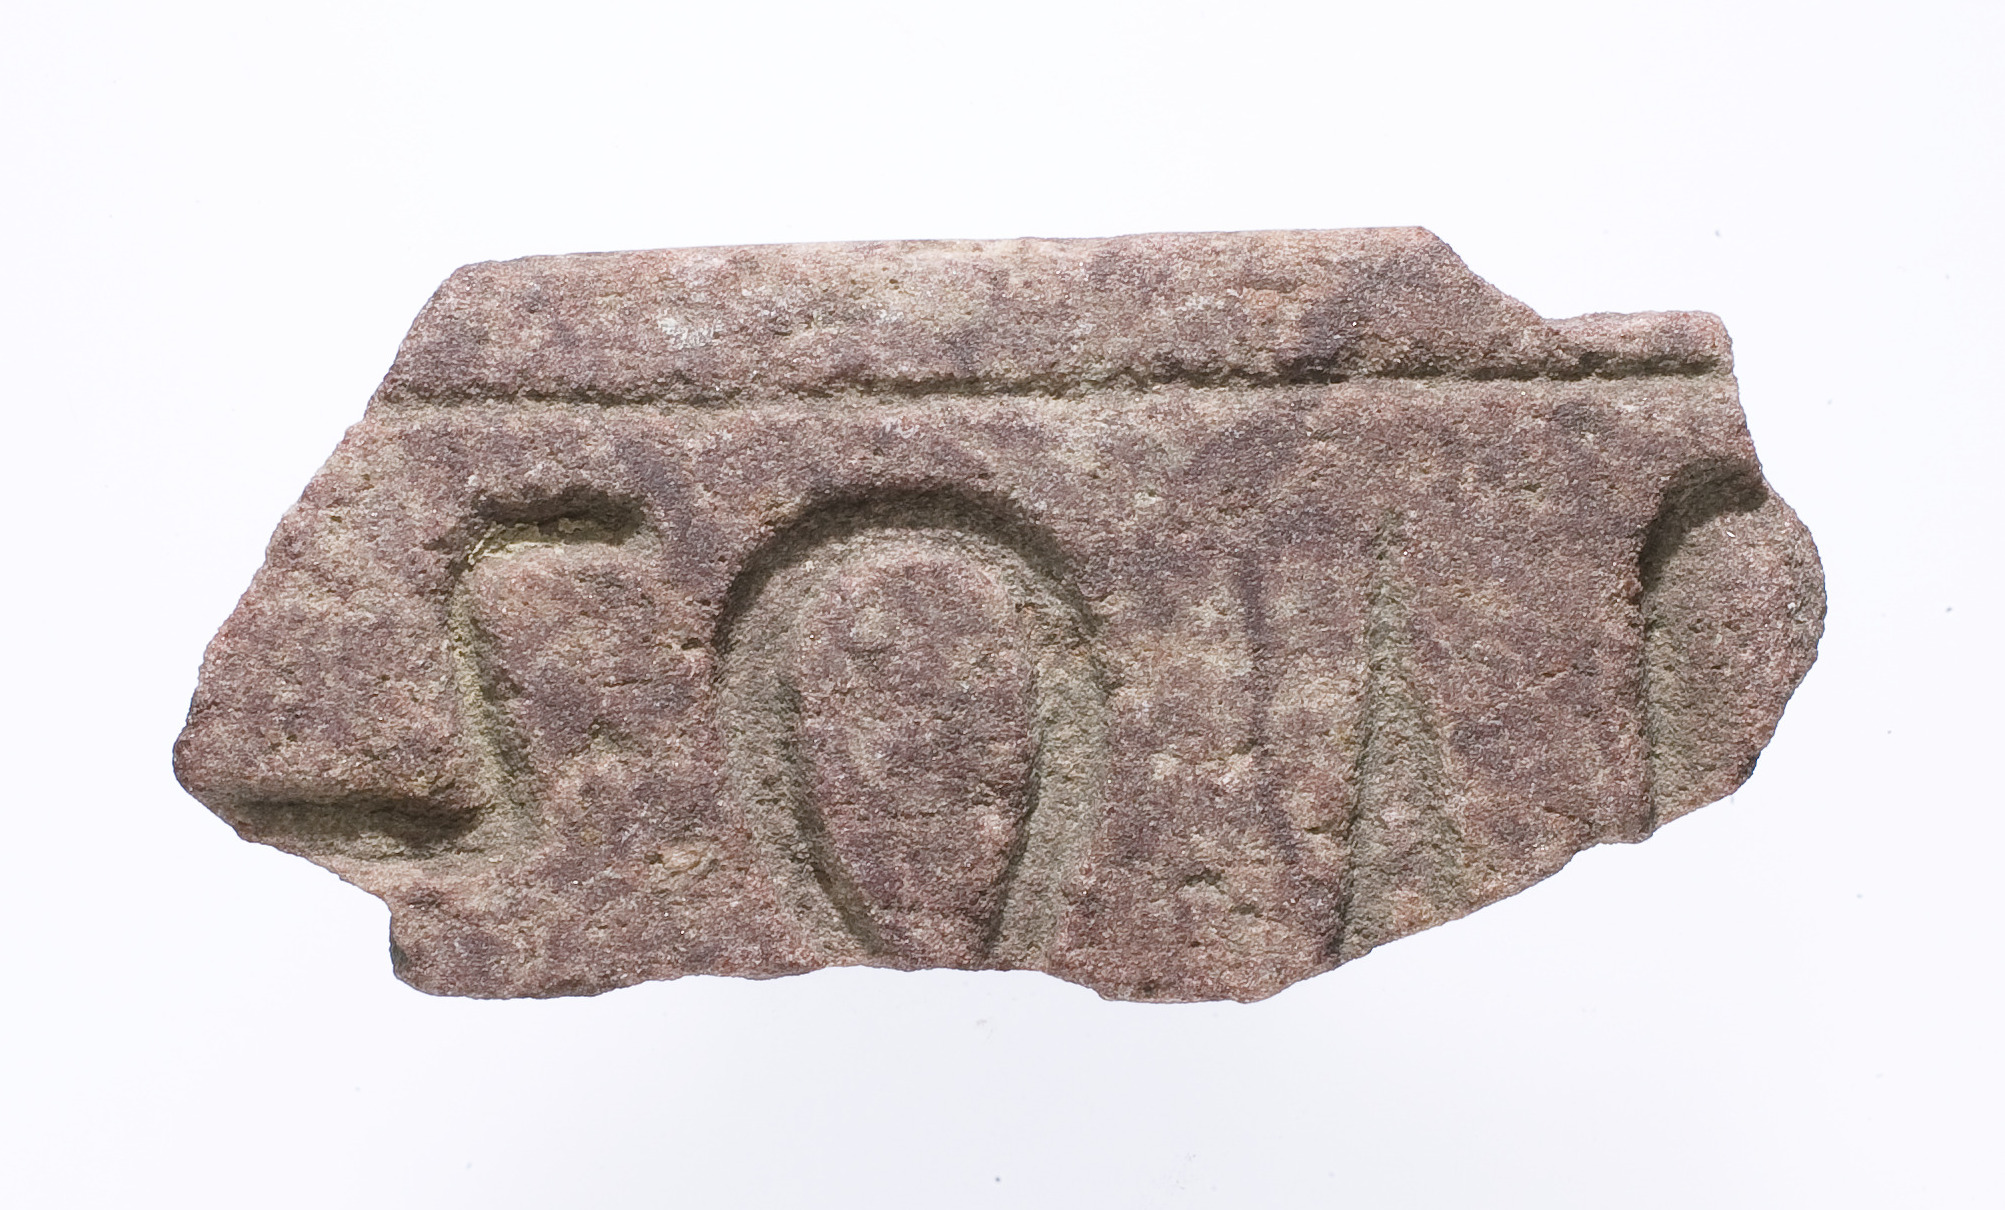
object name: cartouche ending, epithet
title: Element with cartouche ending and following epithets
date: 1353-1336 BCE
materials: quartzite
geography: egypt